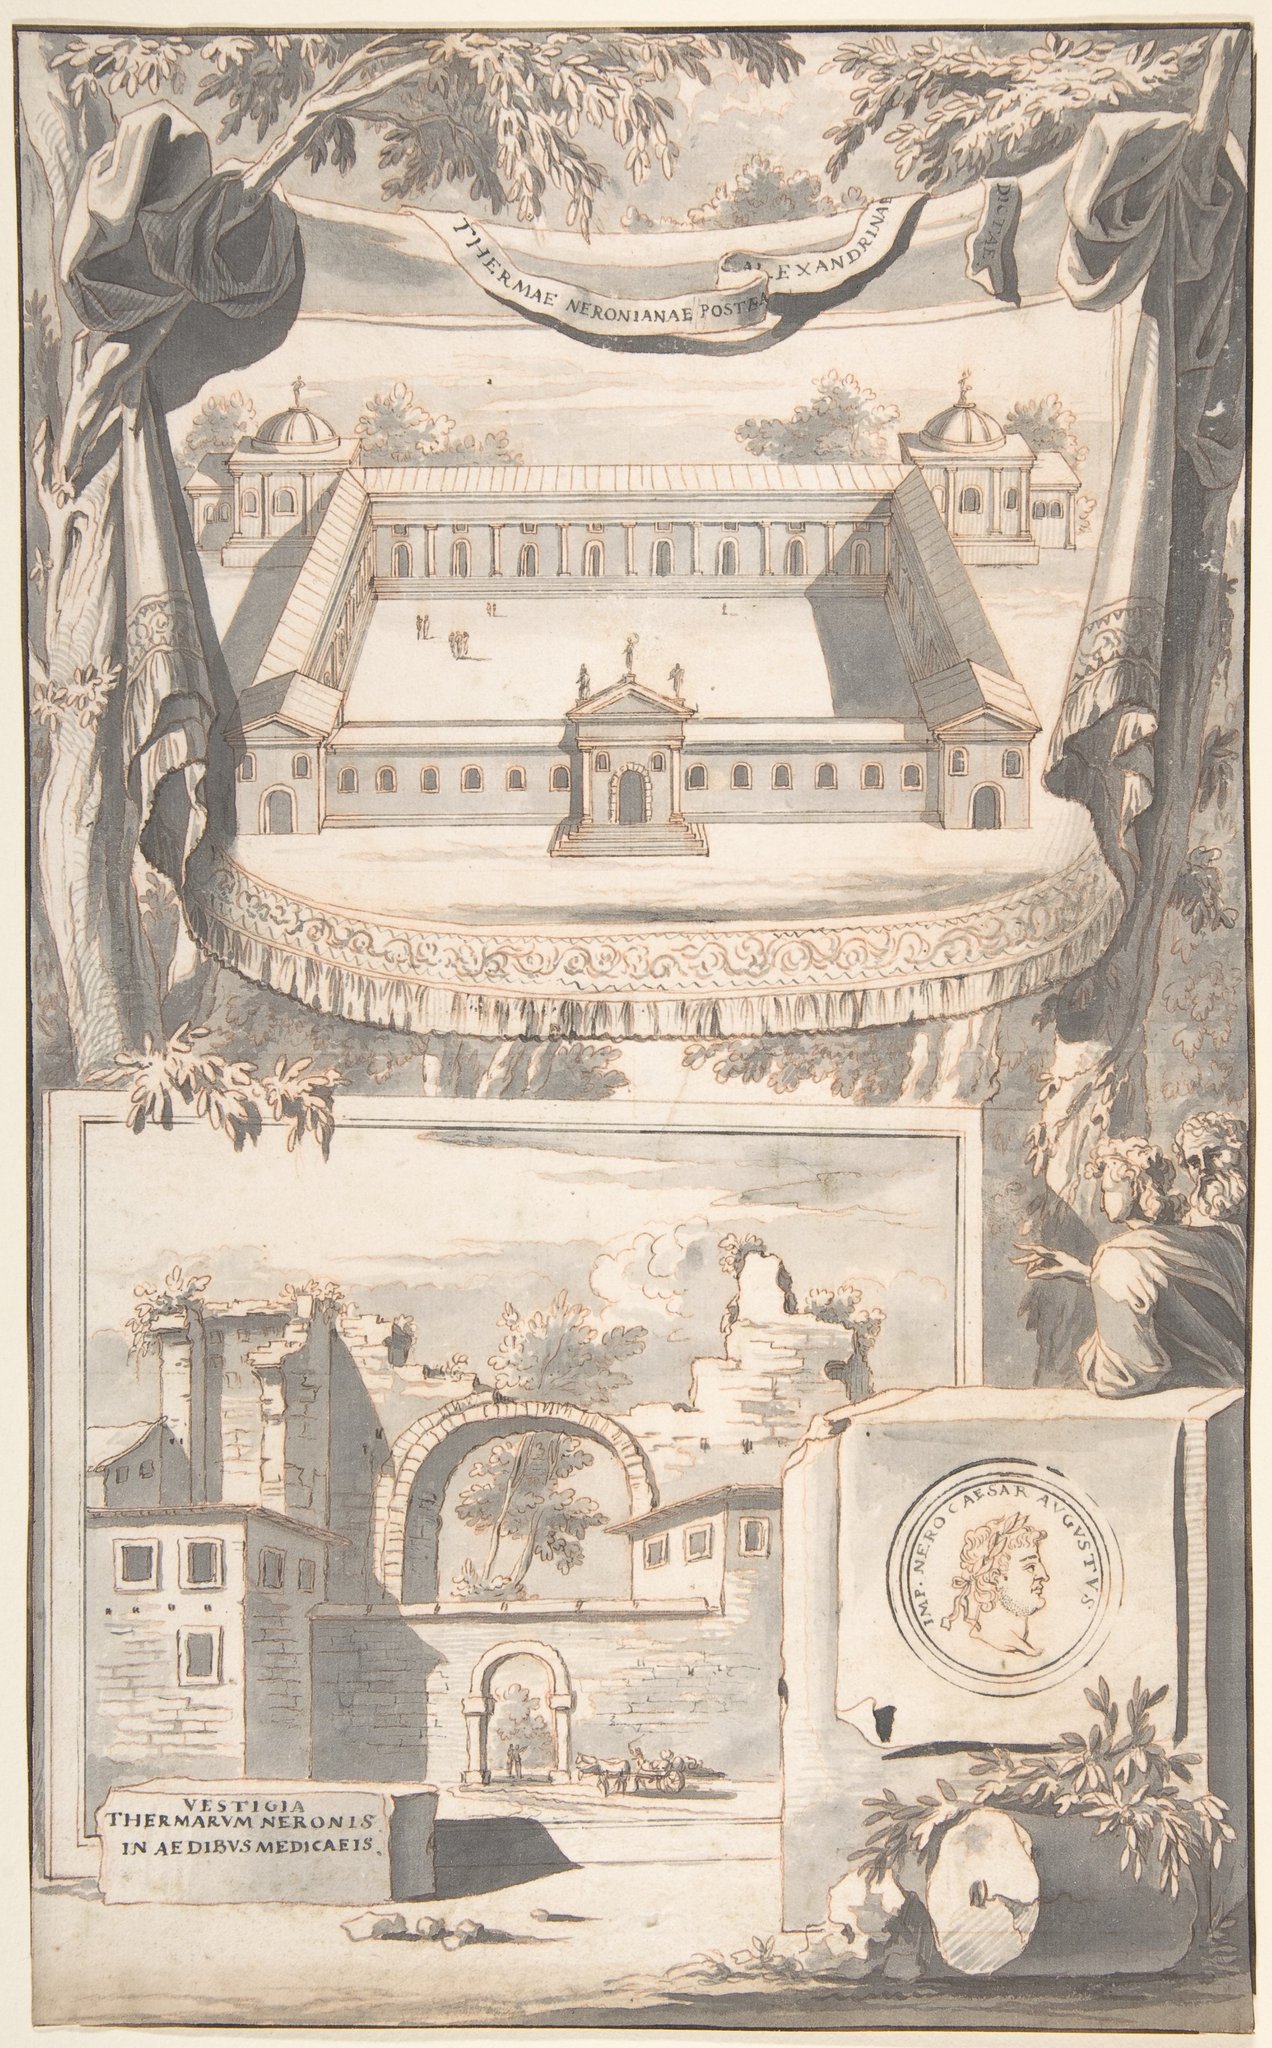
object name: drawing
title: A Reconstruction of the Thermae of Nero (above) and a View of the Ruins (below)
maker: jan goeree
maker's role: artist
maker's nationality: dutch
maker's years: 1670-1731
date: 1704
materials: chalk, ink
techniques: brush, pen, wash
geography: italy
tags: buildings,ruins,men,profiles